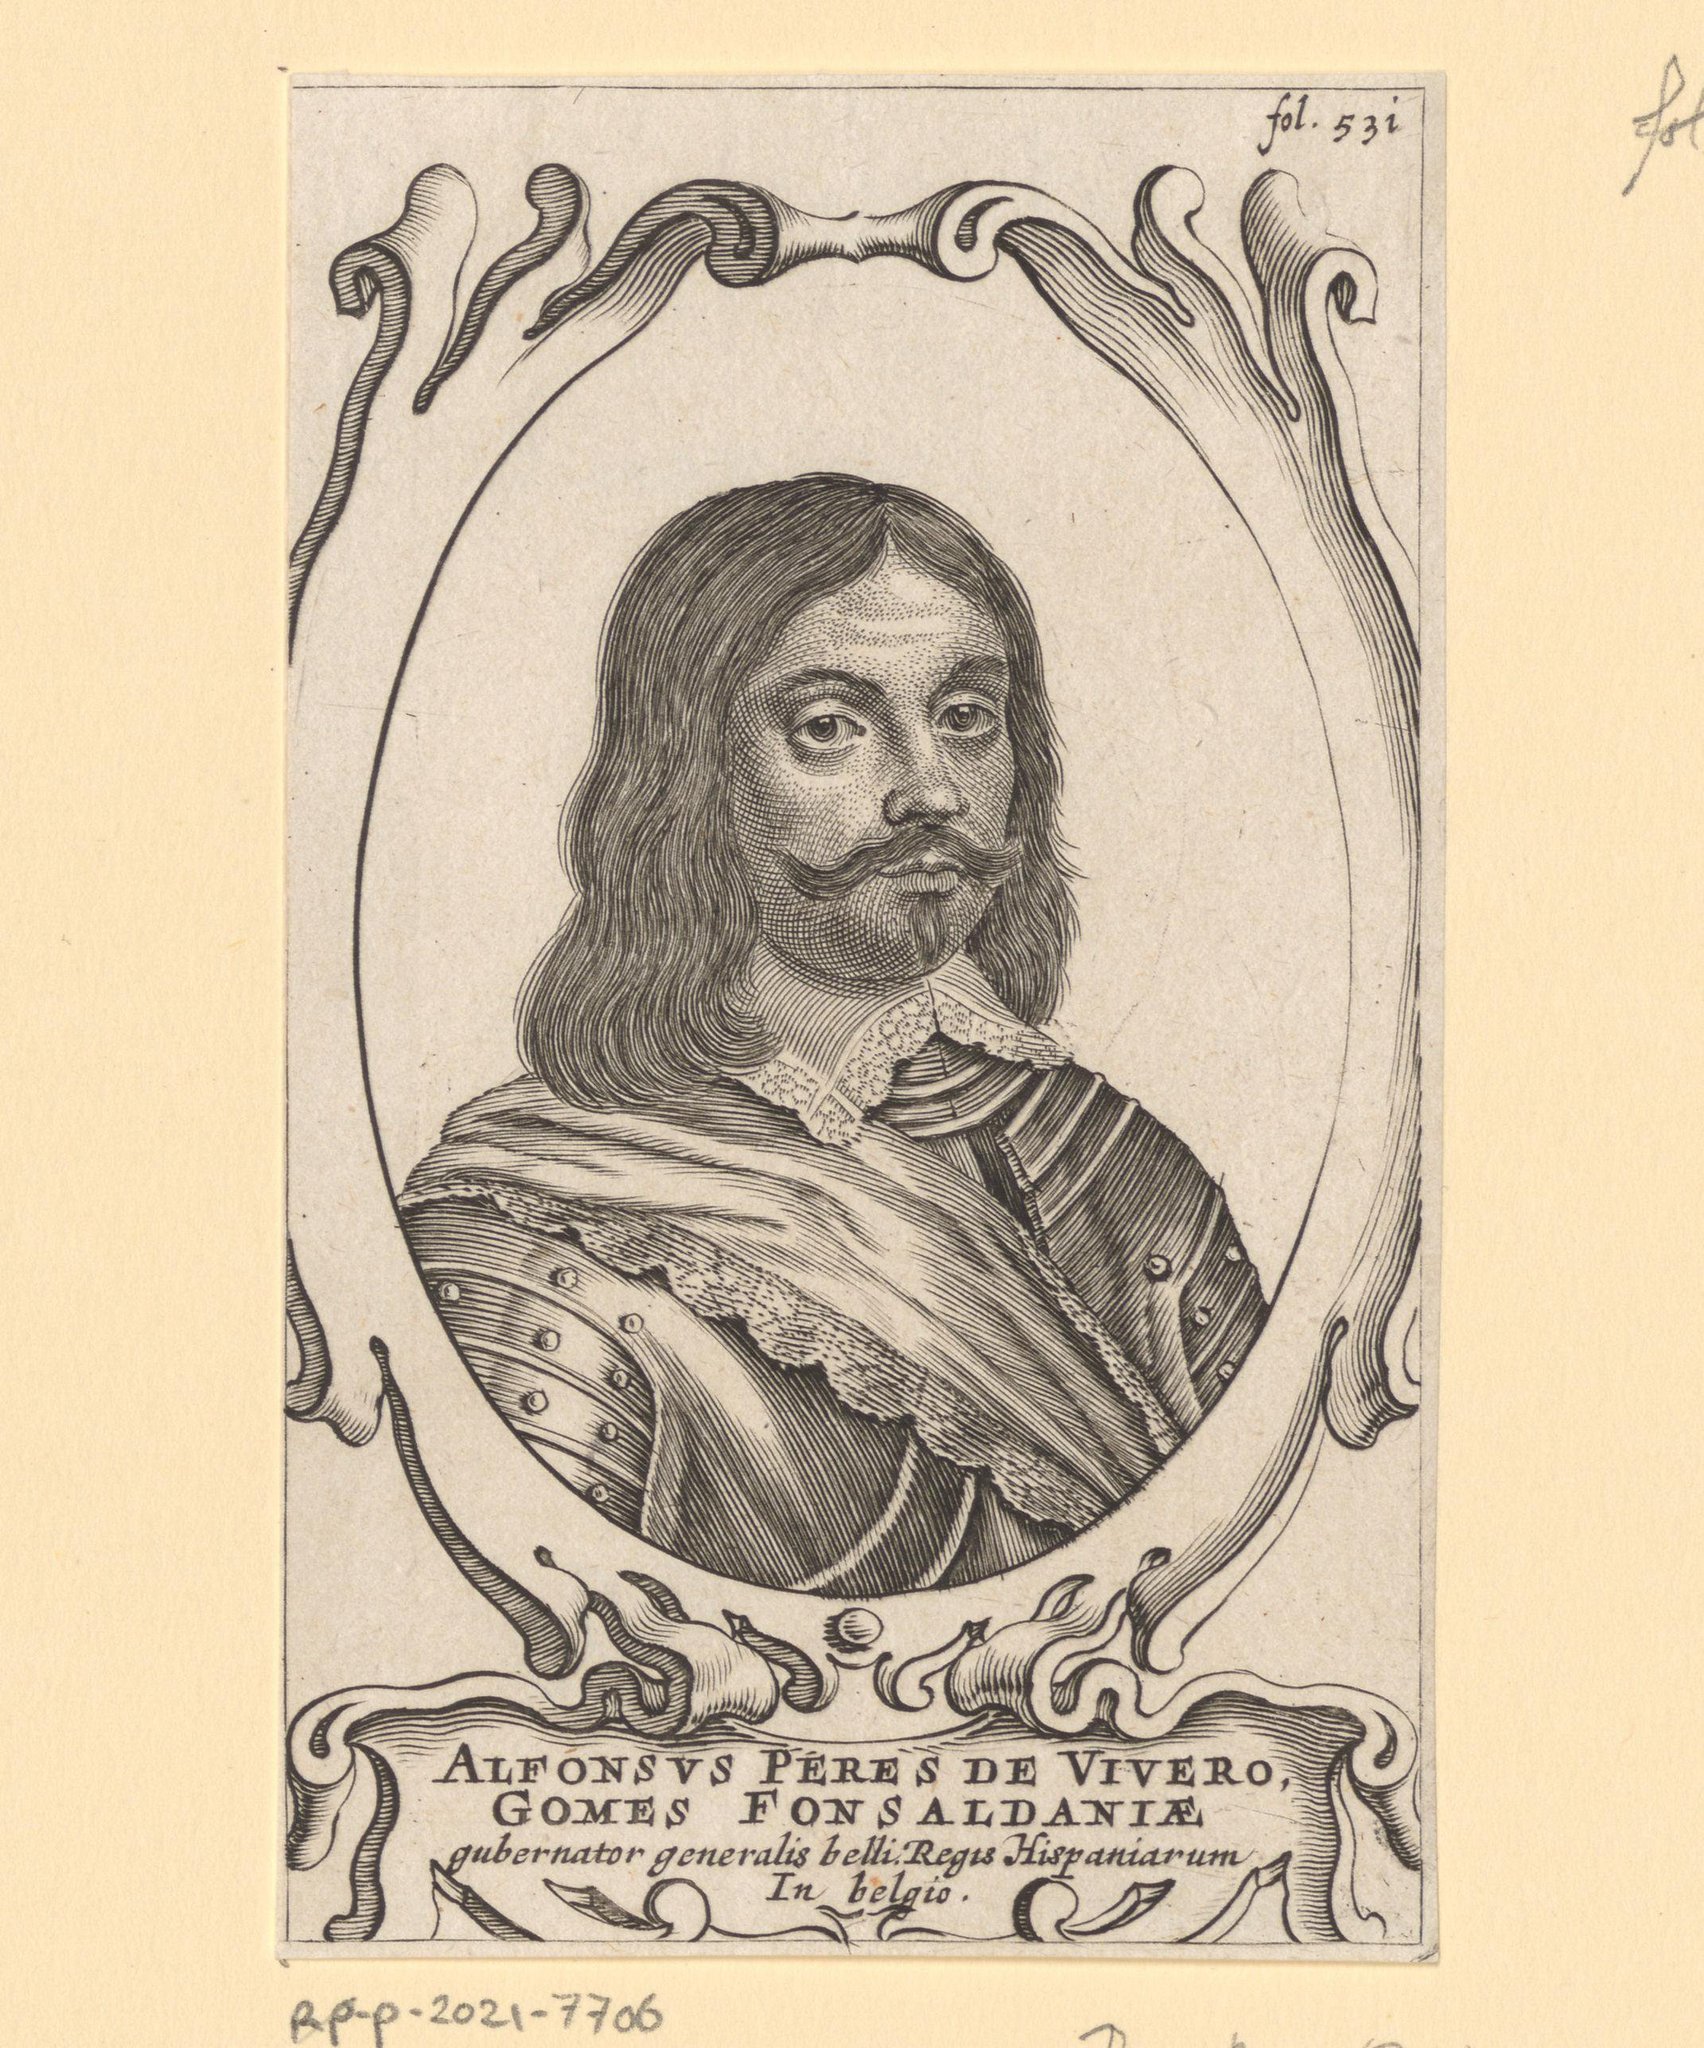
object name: print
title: Portret van Alonso Pérez de Vivero y Menchaca, graaf van Fuensaldaña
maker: Anonymous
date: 1656-1666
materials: paper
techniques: engraving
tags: alonso pérez de vivero y menchaca (graaf van fuensaldaña), adult man, historical persons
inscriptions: inscription: ‘996’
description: Prent mogelijk uit: Brachelius, Johannes Adolphus. Historia nostri temporis, dat is geschiedenis onses tijts (…). Rotterdam: Andries van Hoogenhuysen, 1656. Of uit een latere editie (1659, 1666).